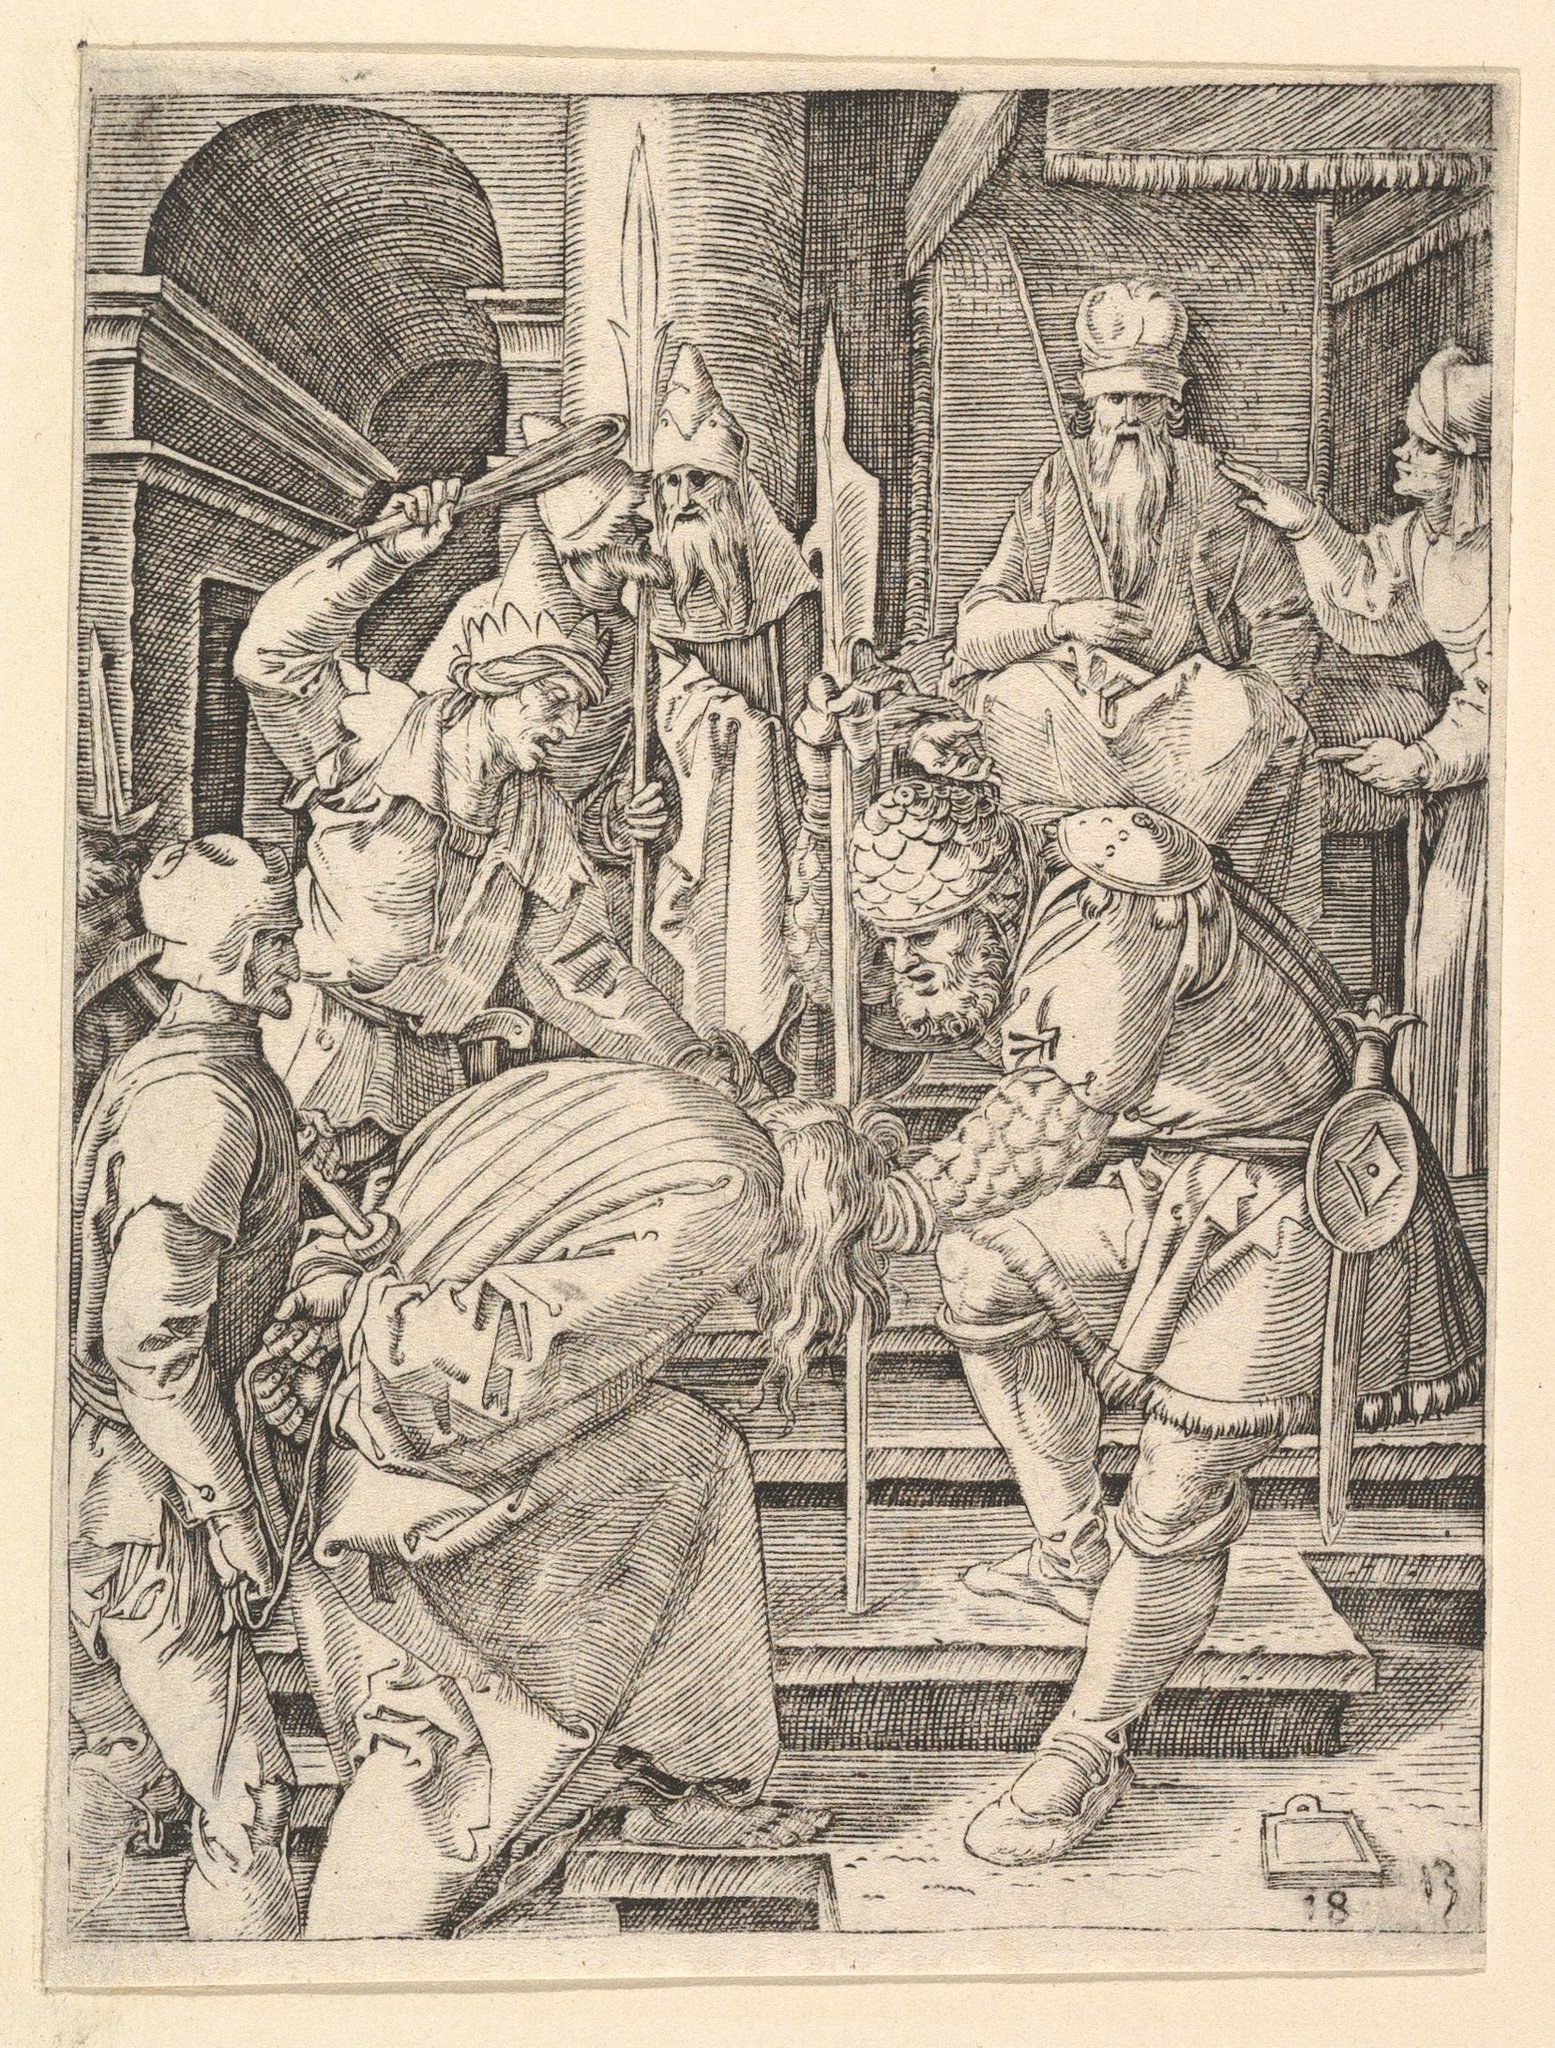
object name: print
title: Christ captured and being dragged by hair up steps before the throne of the high priest Annas, from "The Passion of Christ", after Dürer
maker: marcantonio raimondi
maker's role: artist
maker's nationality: italian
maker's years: 1475-1534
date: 1500-1534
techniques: engraving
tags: soldiers,swords,christ